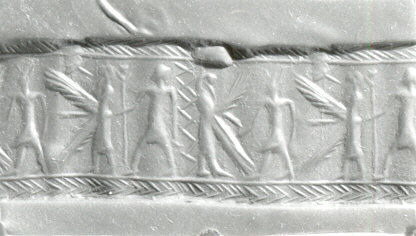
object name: cylinder seal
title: Cylinder seal with gold caps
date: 1720-1600 BCE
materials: gemstone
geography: egypt or syria